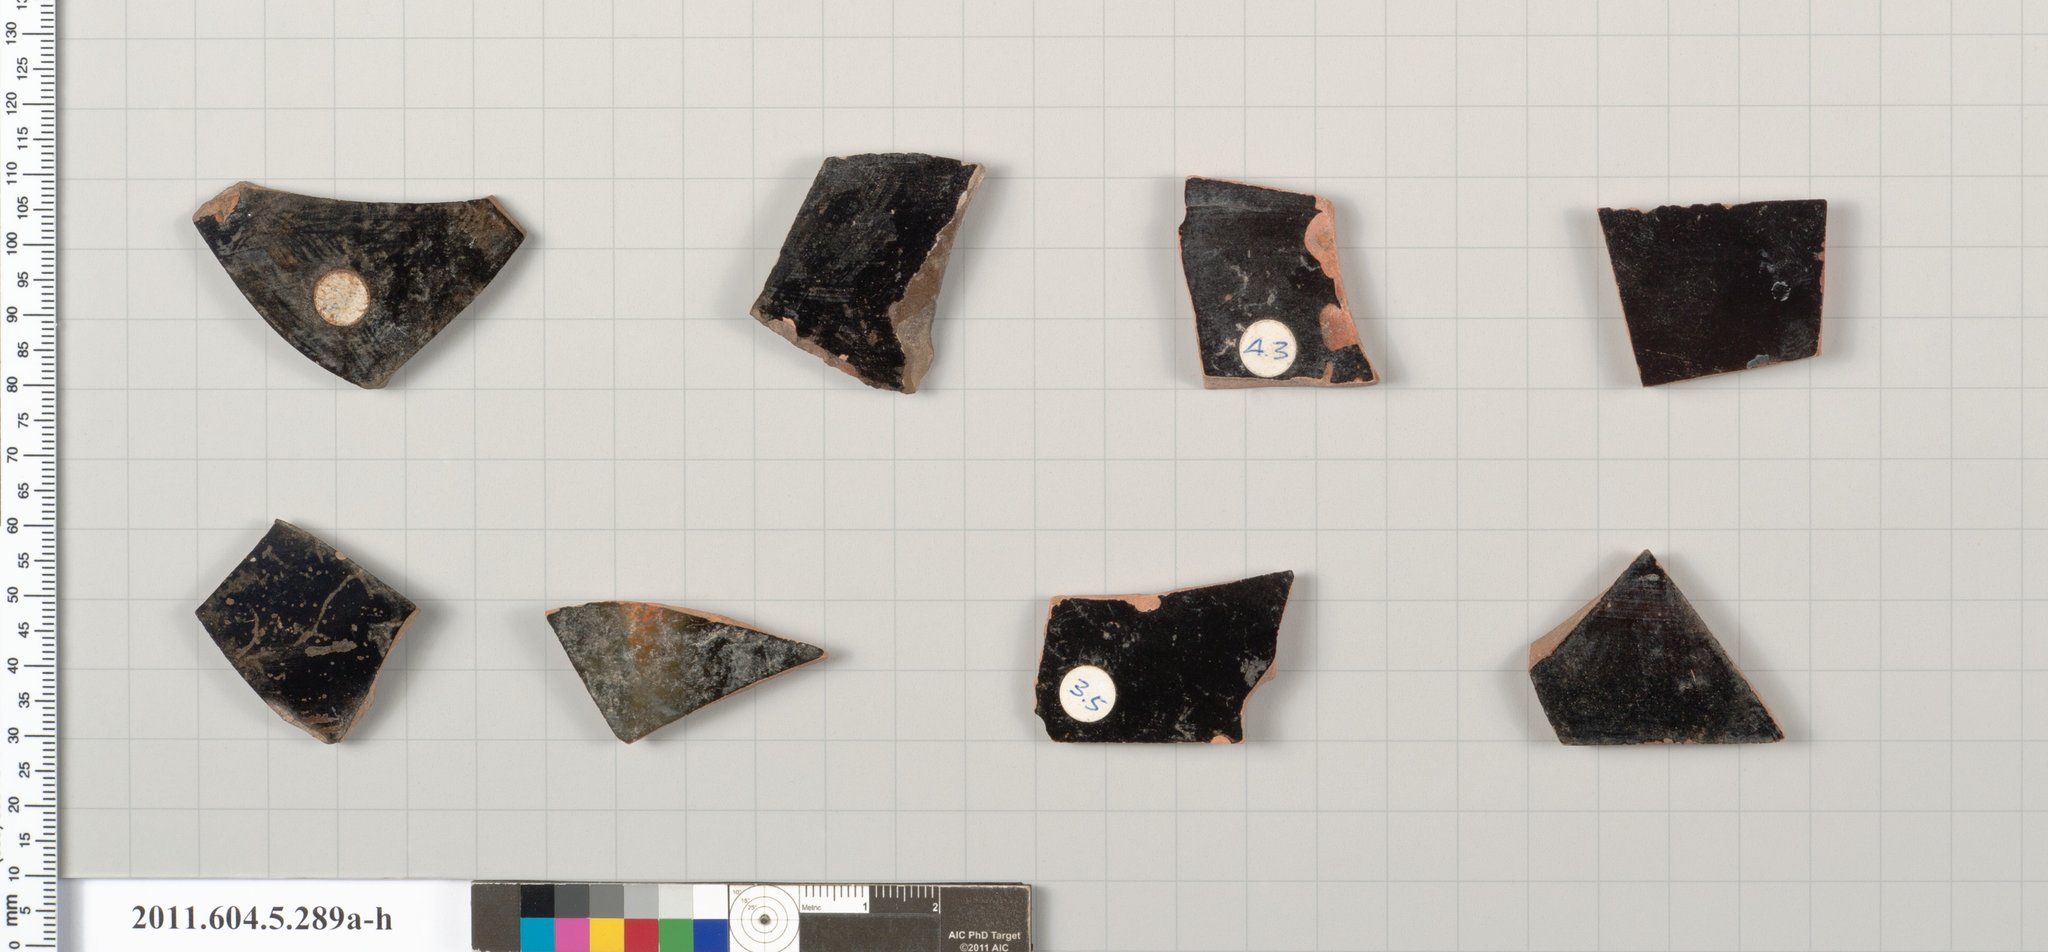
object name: kylix fragment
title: Terracotta fragments of kylikes (drinking cups)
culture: greek, attic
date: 600-401 BCE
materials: terracotta